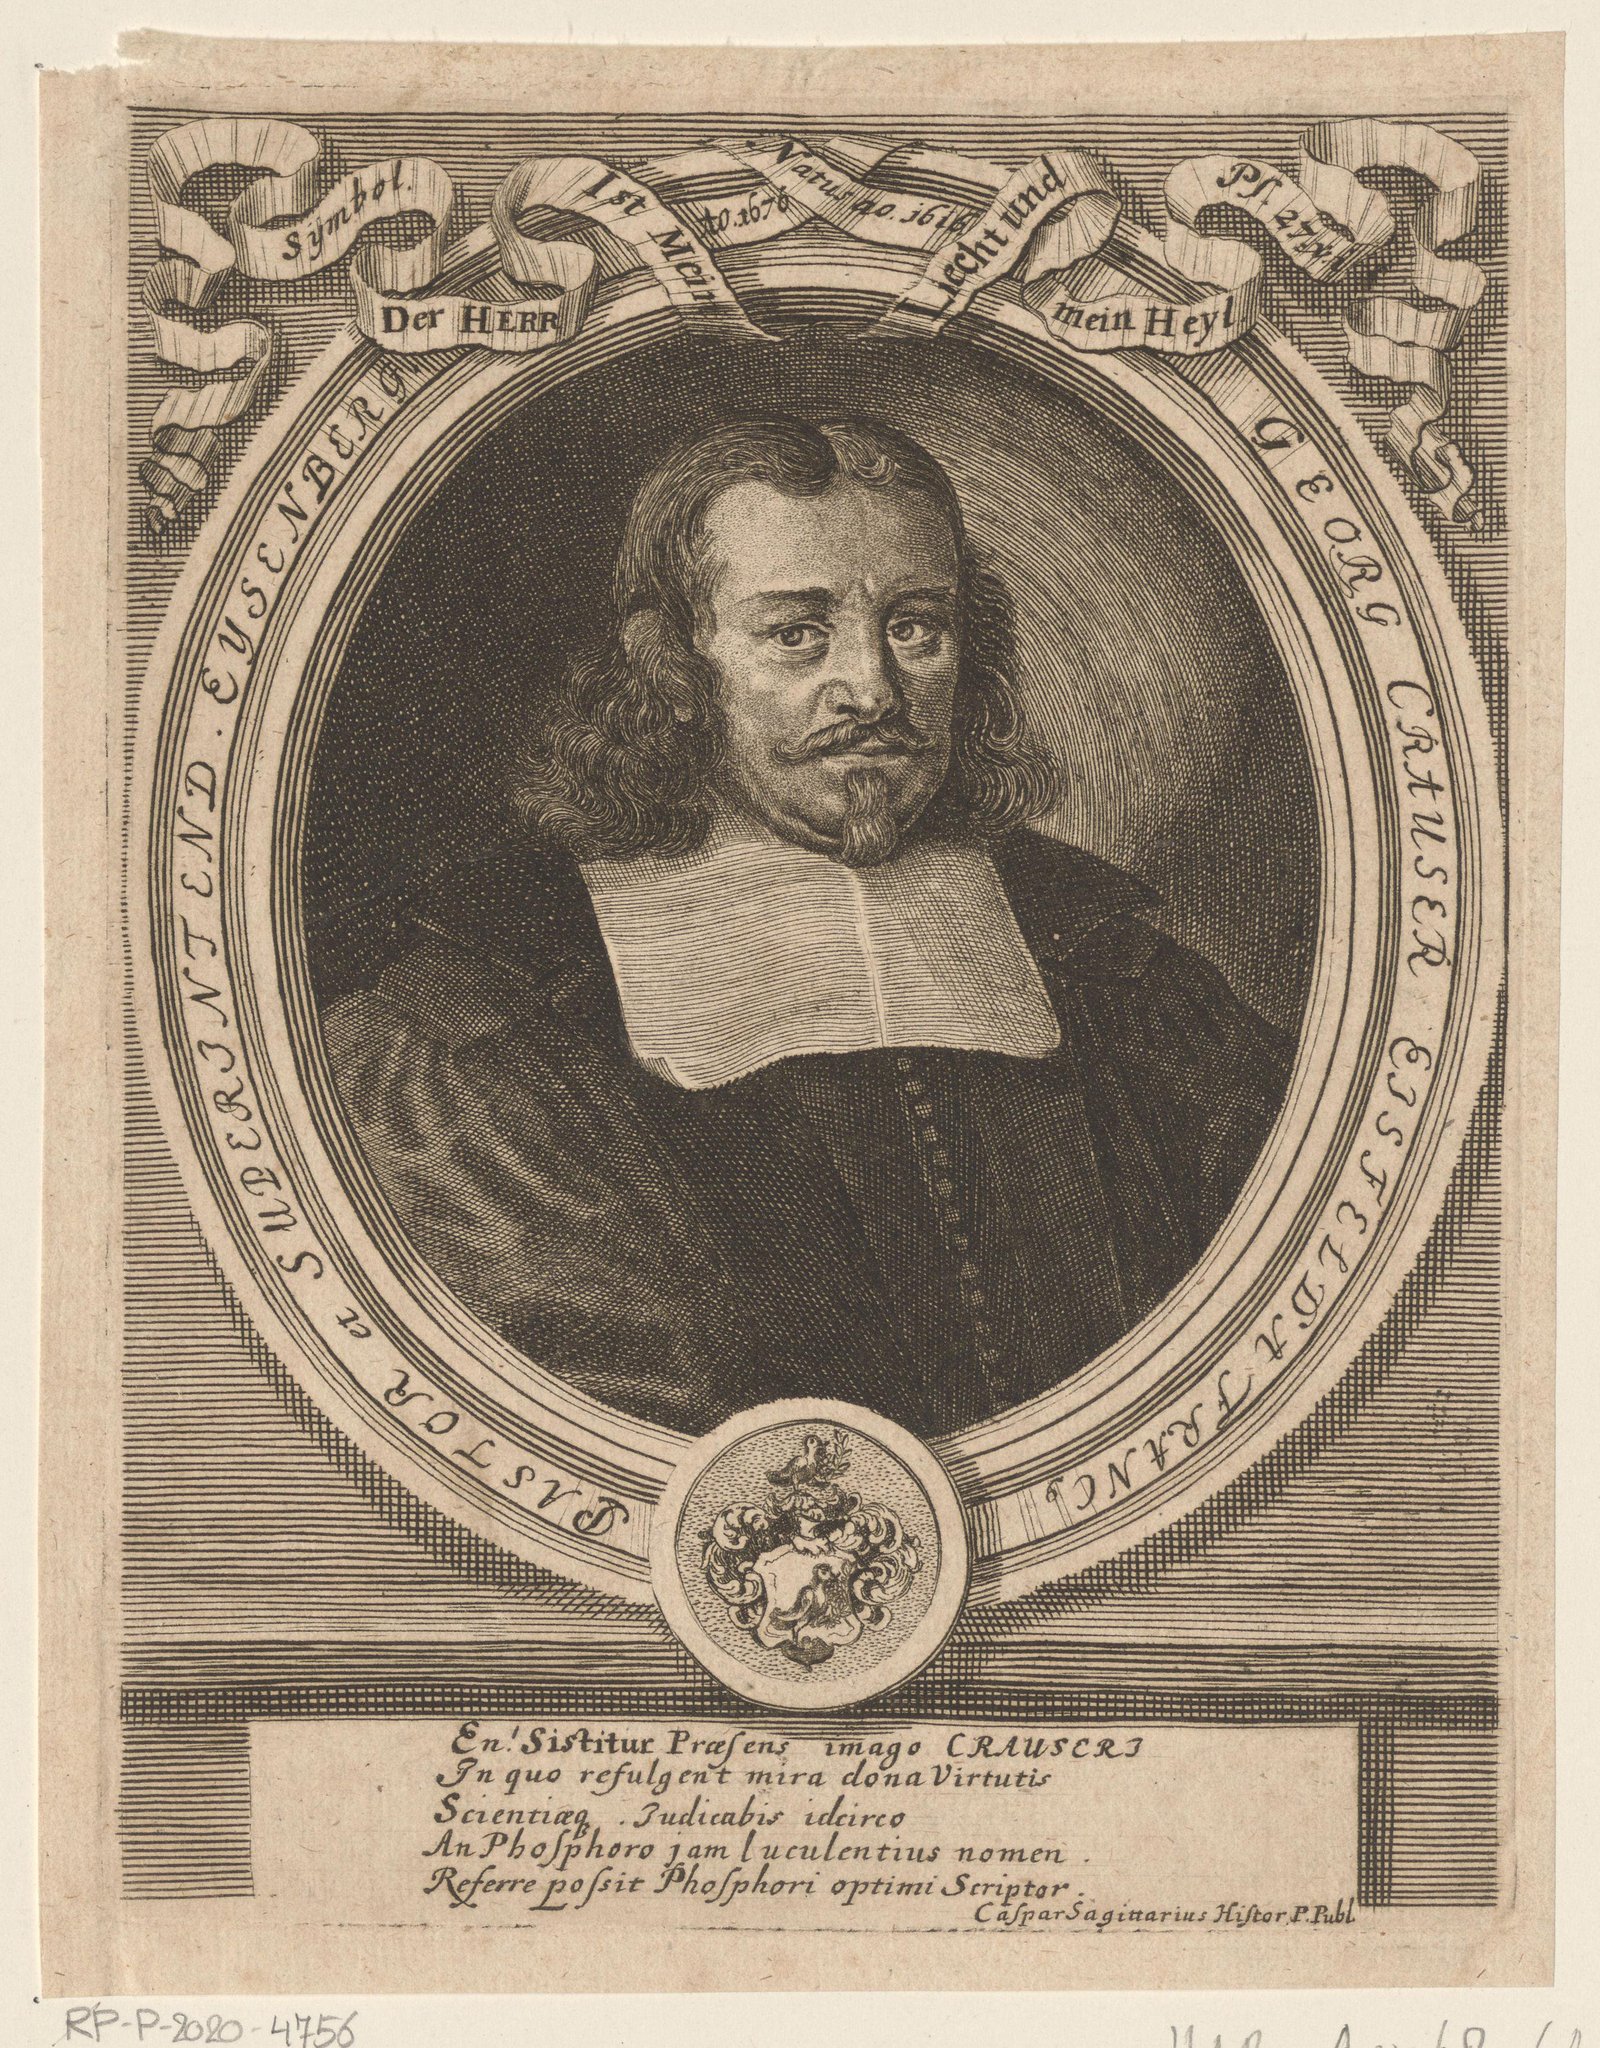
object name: print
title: Portret van Georg Crauser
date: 1643-1699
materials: paper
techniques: engraving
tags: historical persons